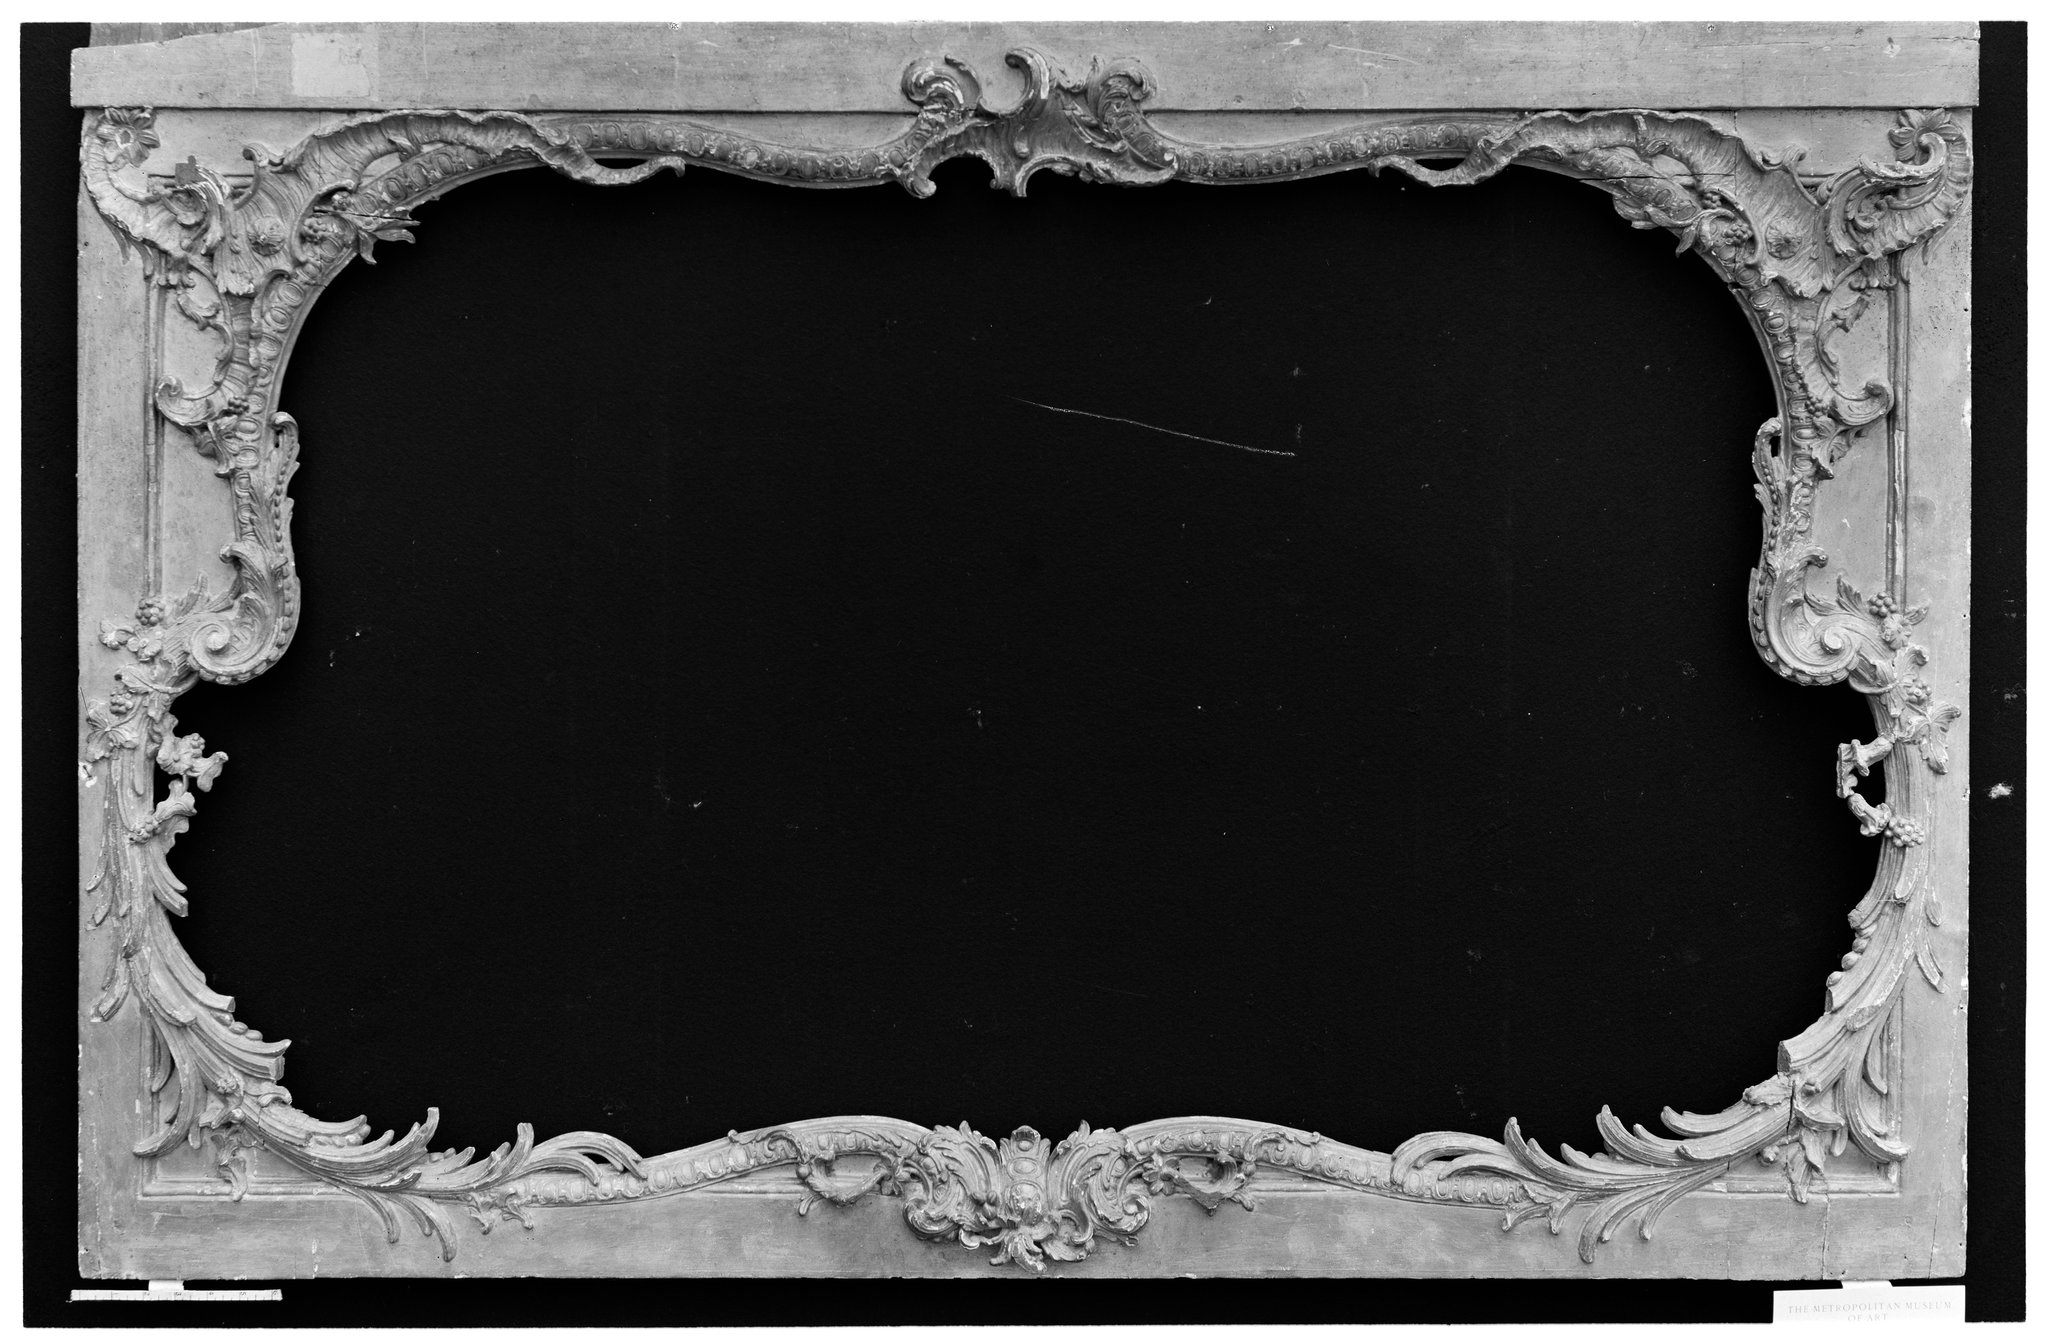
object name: overdoor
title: Overdoor (Dessus de porte)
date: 1701-1800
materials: wood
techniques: carving, gilding